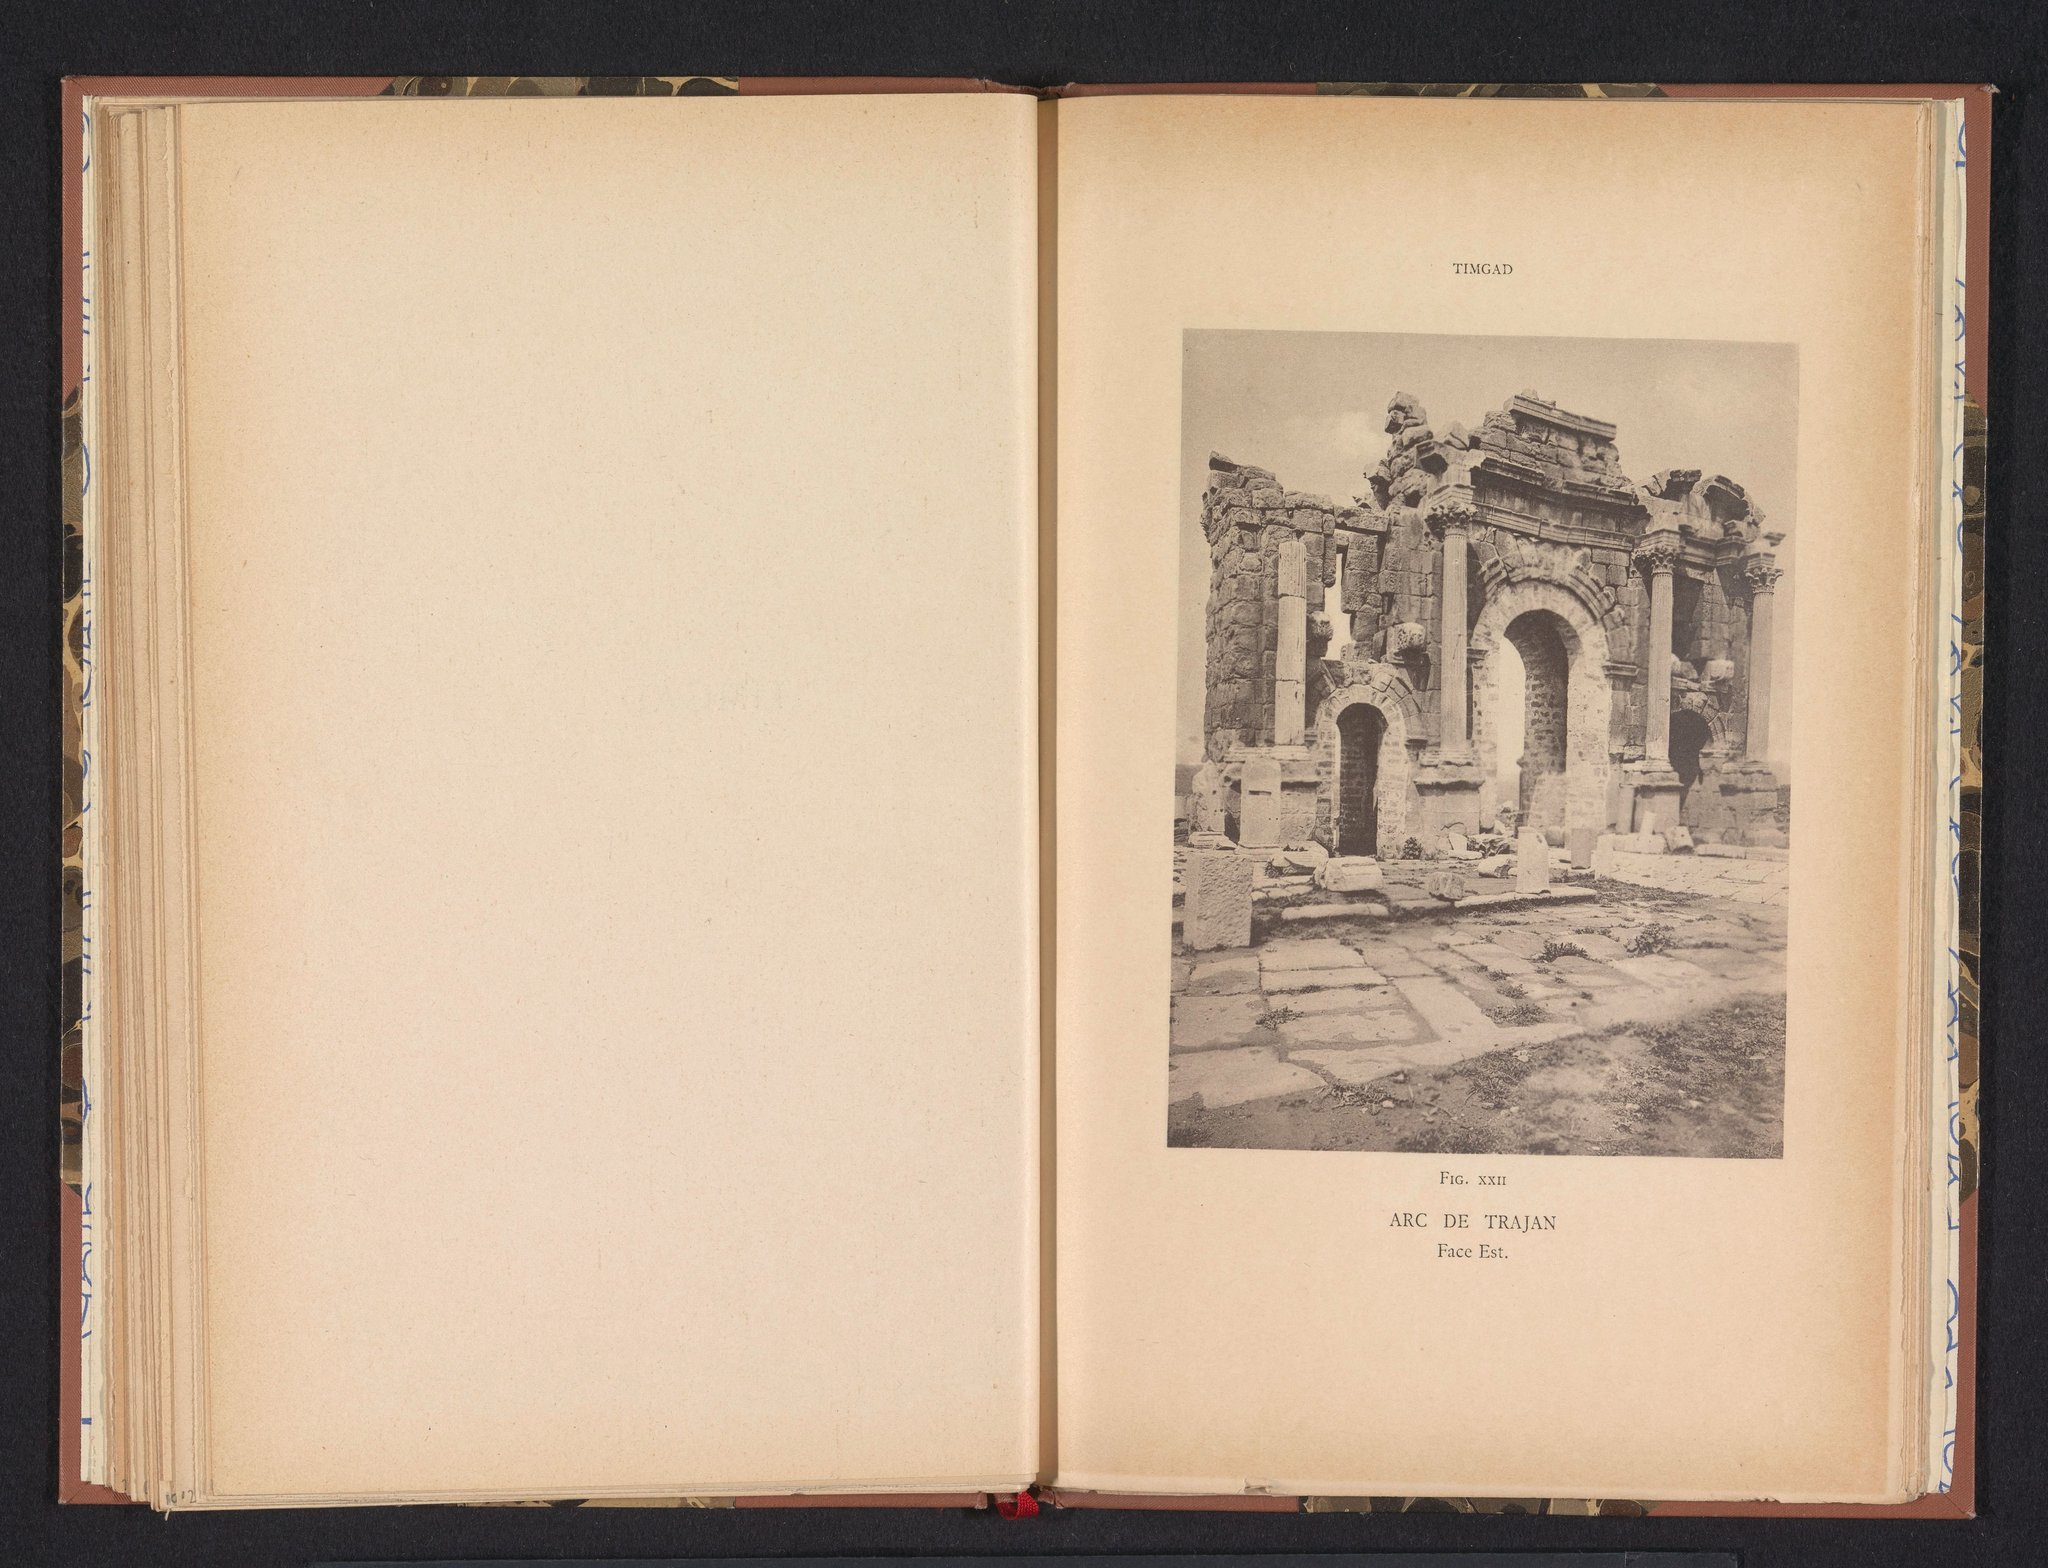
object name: page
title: Gezicht op de boog van Trajanus in Timgad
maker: Anonymous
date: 1884-1894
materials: paper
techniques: photograph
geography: france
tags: triumphal arch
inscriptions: number: ‘Fig. XXII’